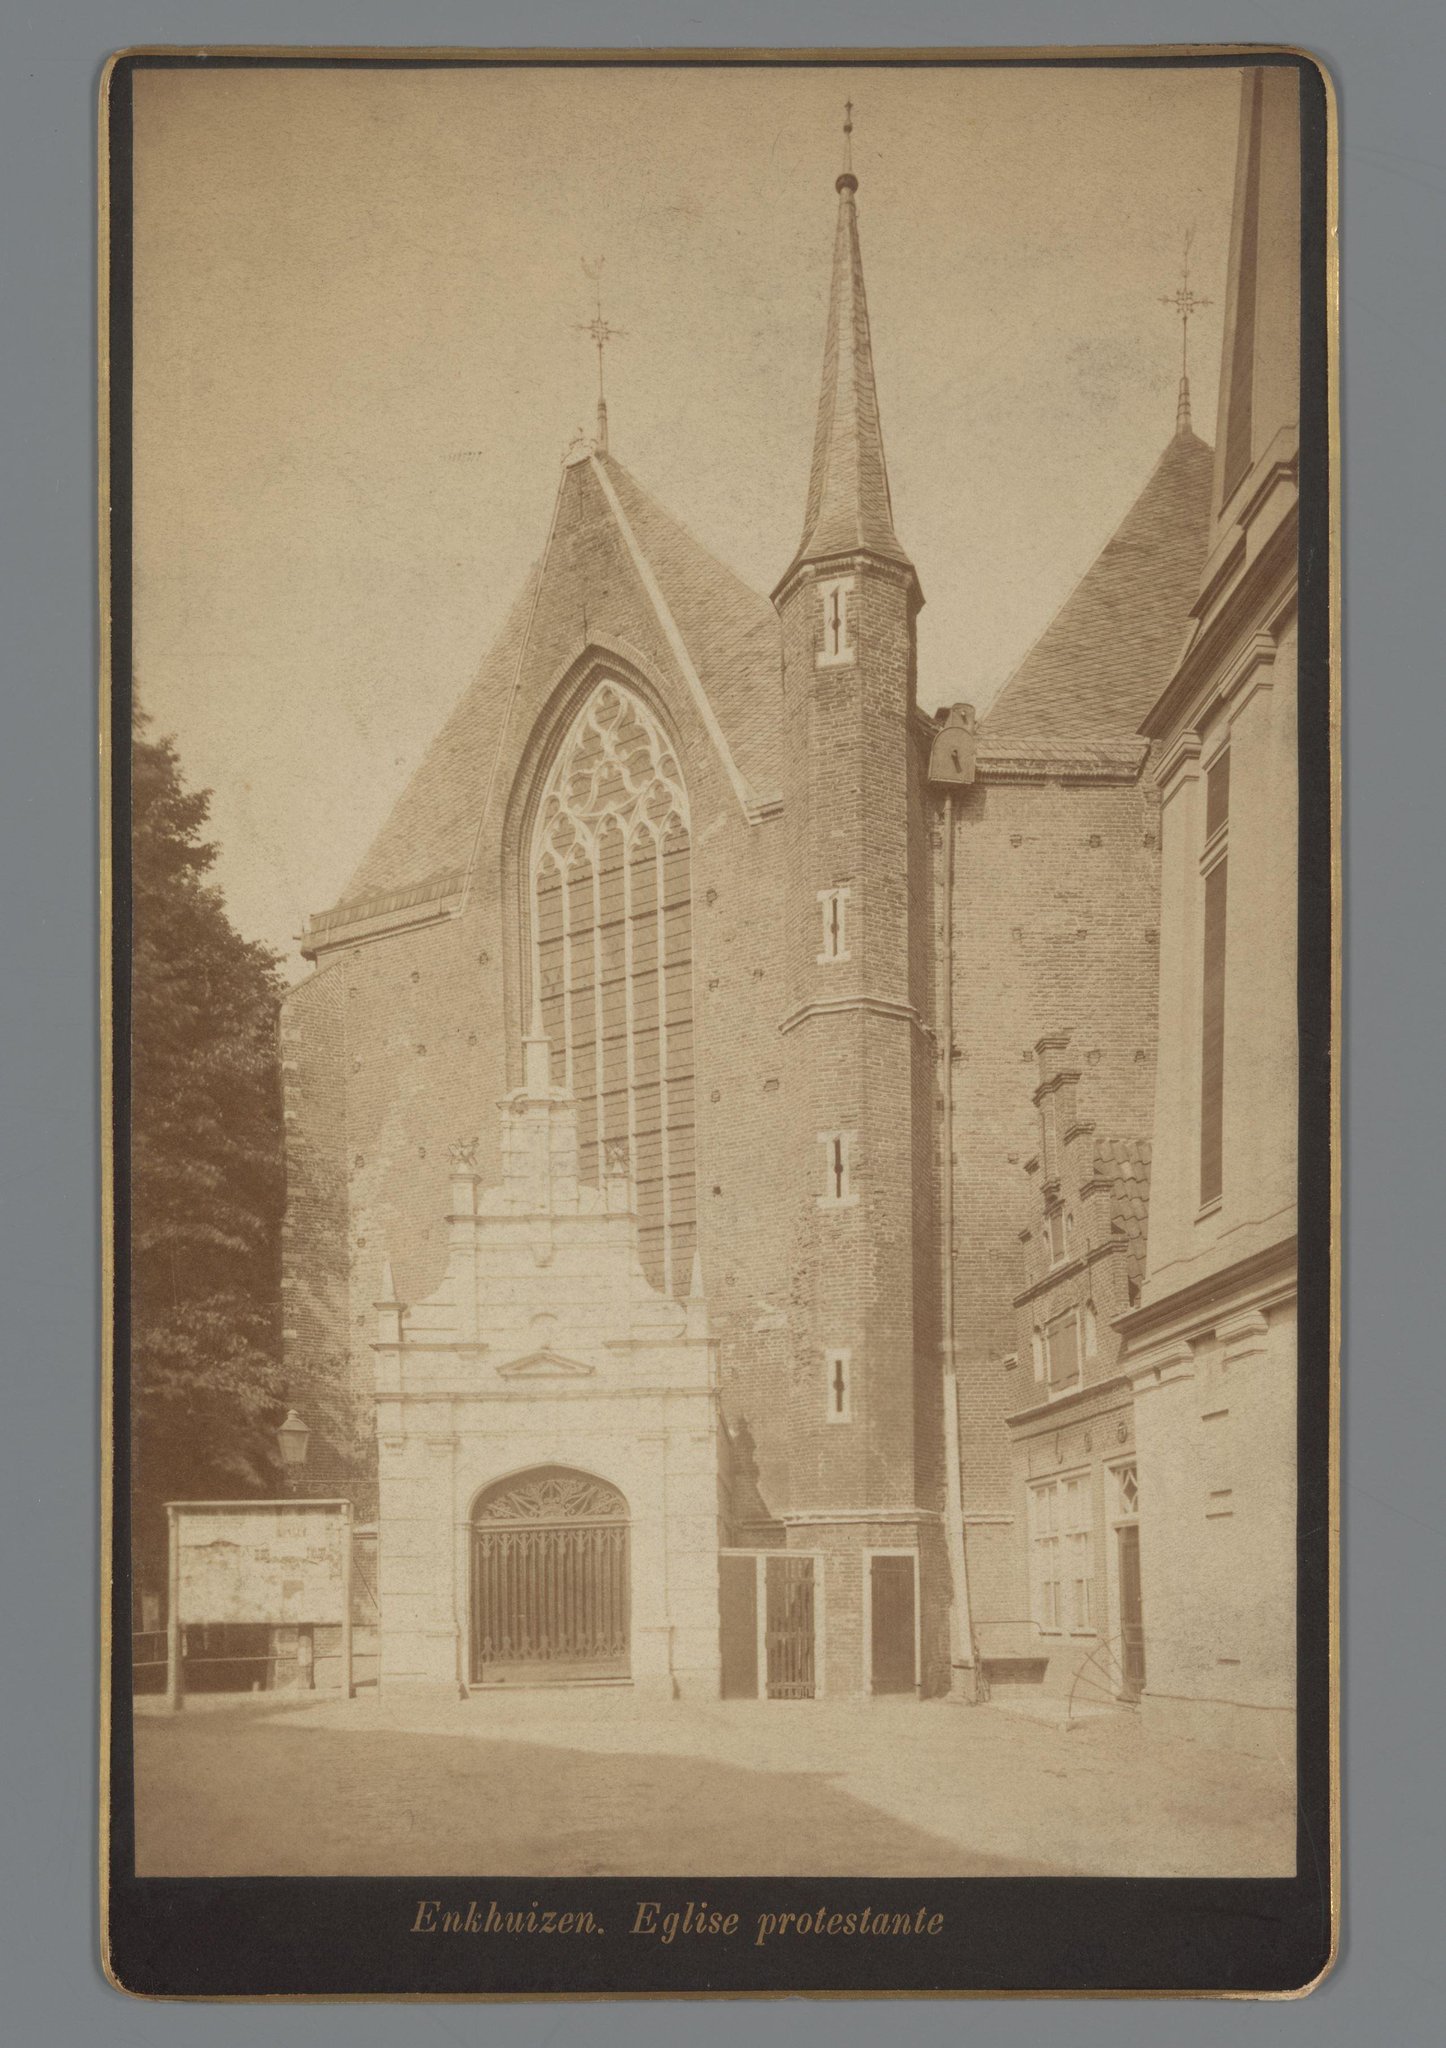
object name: photograph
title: Gedeelte van de Zuiderkerk te Enkhuizen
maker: Anonymous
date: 1870-1900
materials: cardboard, photographic support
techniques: albumen print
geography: enkhuizen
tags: church (exterior), enkhuizen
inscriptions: inscription: ‘Enkhuizen/ Eglise protestante’